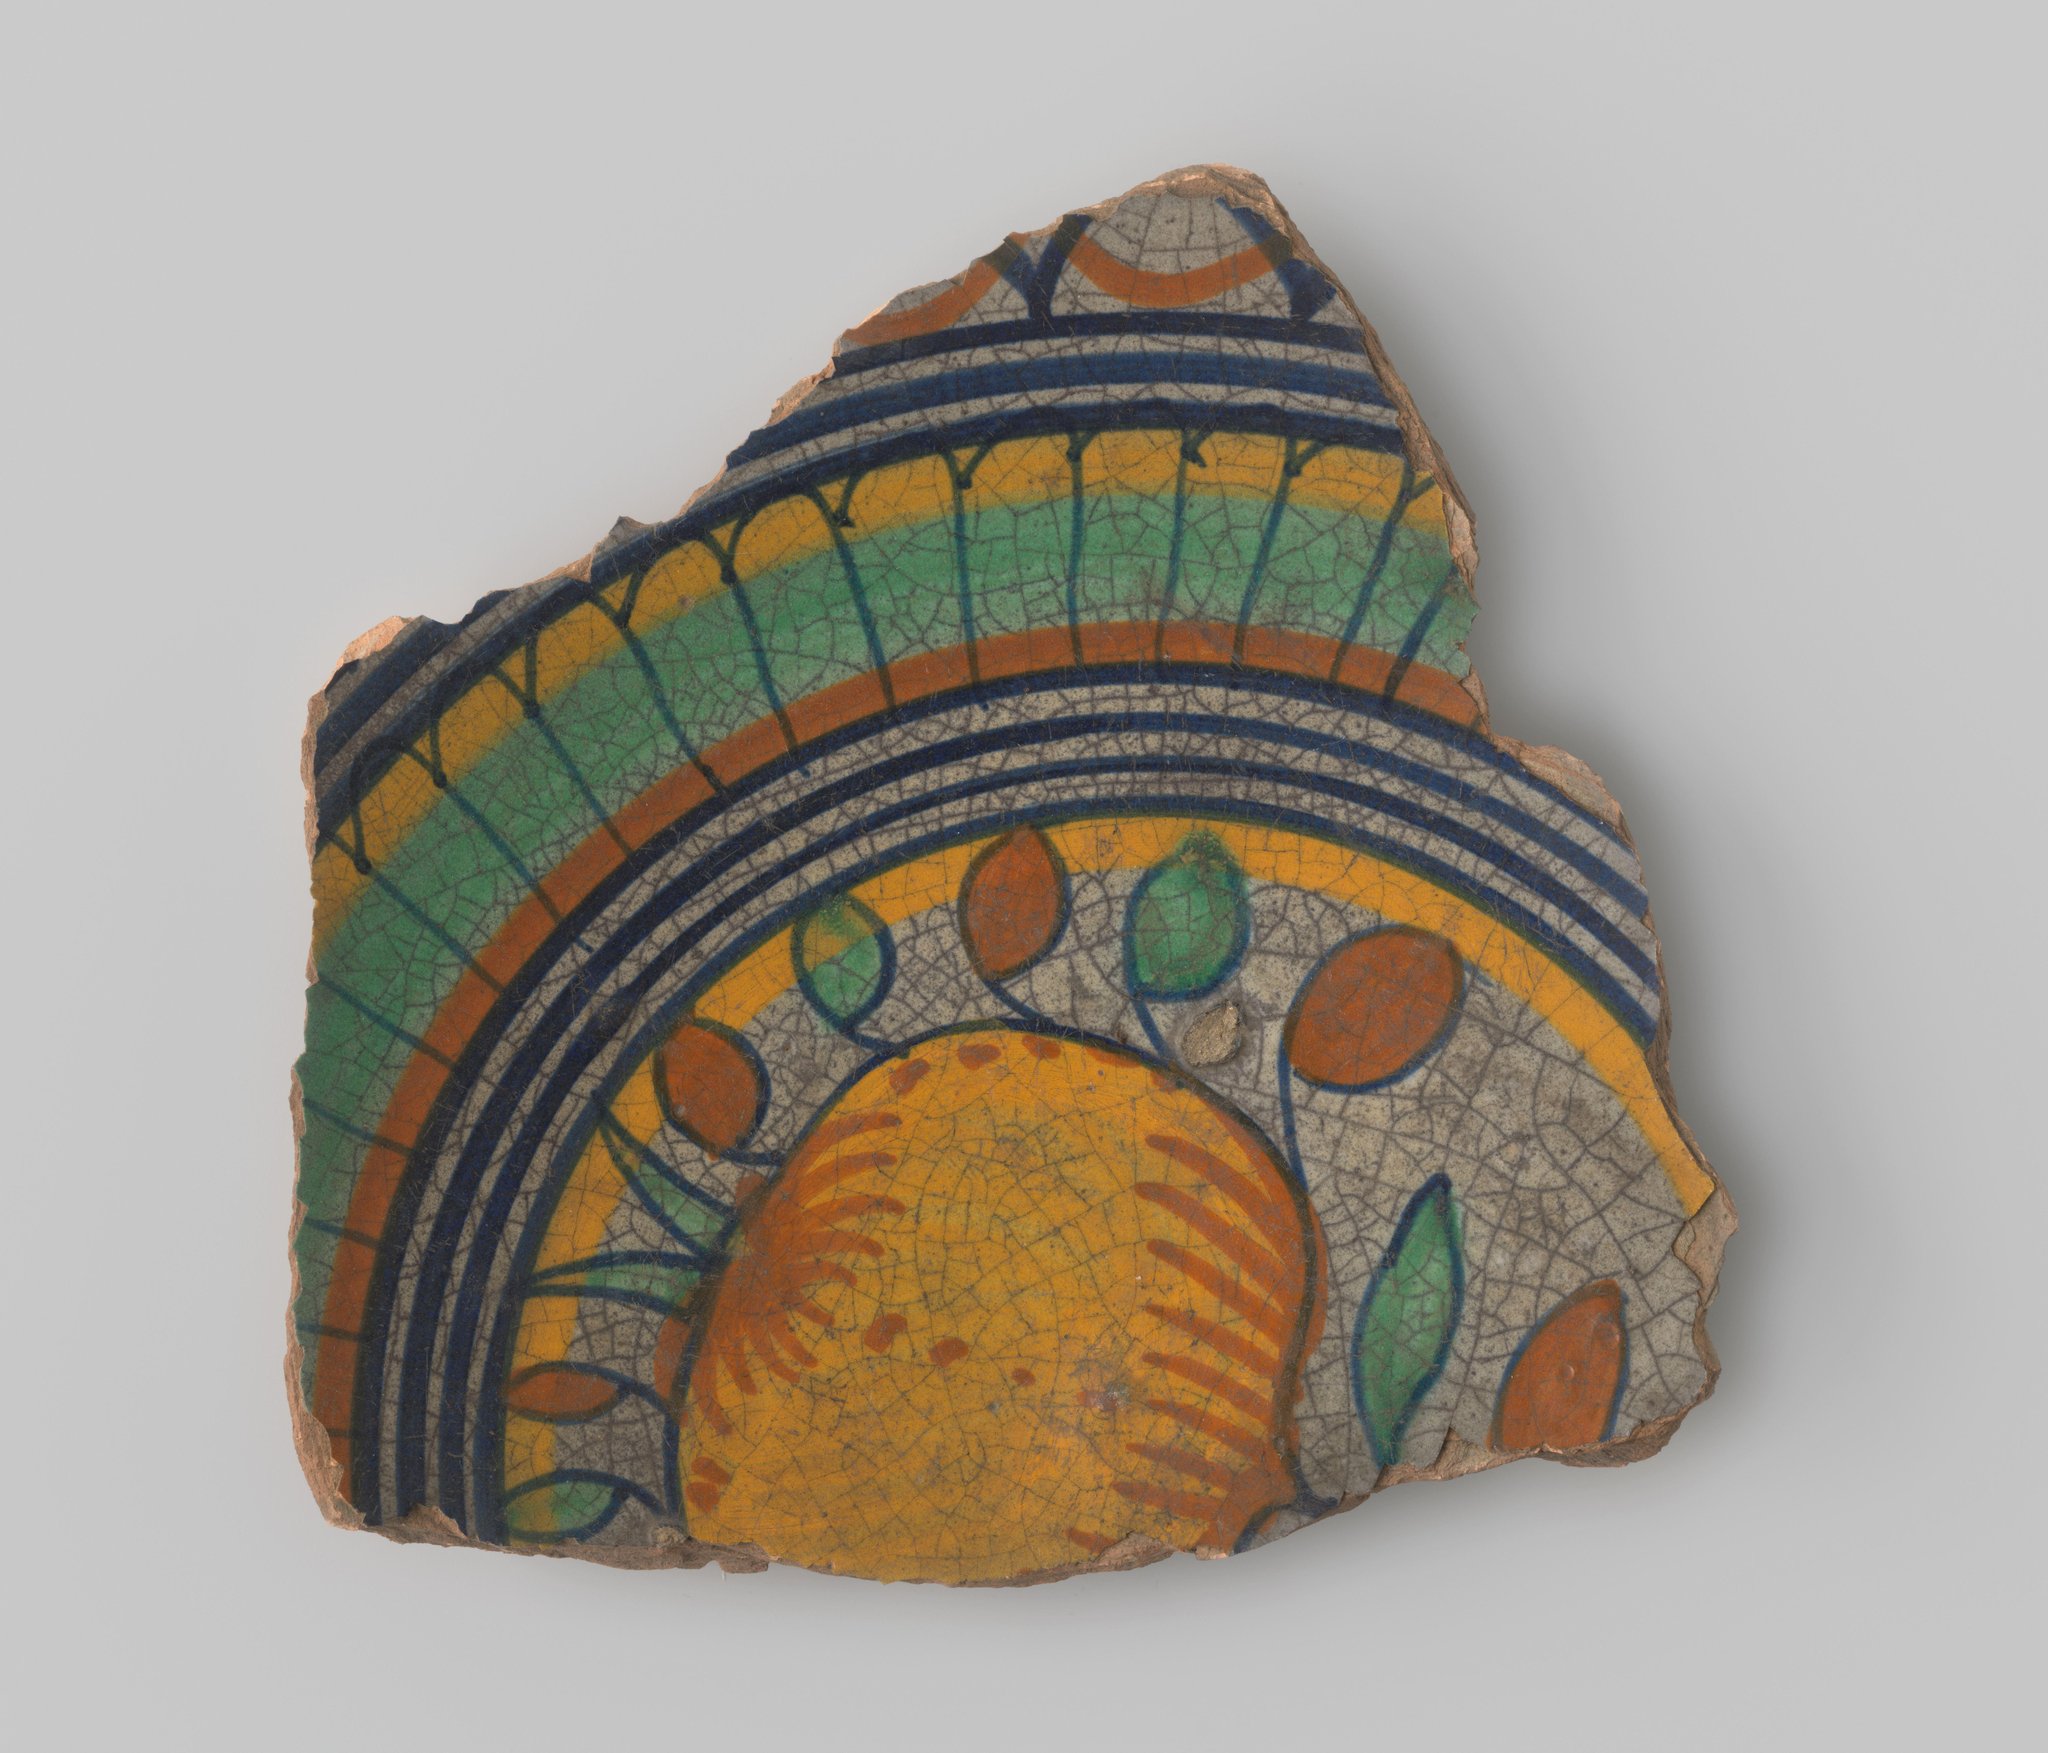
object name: platter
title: Fragment van een schotel van aardewerk, versierd met granaatappel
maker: Anonymous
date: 1600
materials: earthenware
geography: northern netherlands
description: Fragment van een schotel van aardewerk in geel, oranje, groen en blauw, versierd met een granaatappel. pen en in blauwe grond weggekraste ornamenten. Merk aOpmerking: opgegraven te Dordrecht.